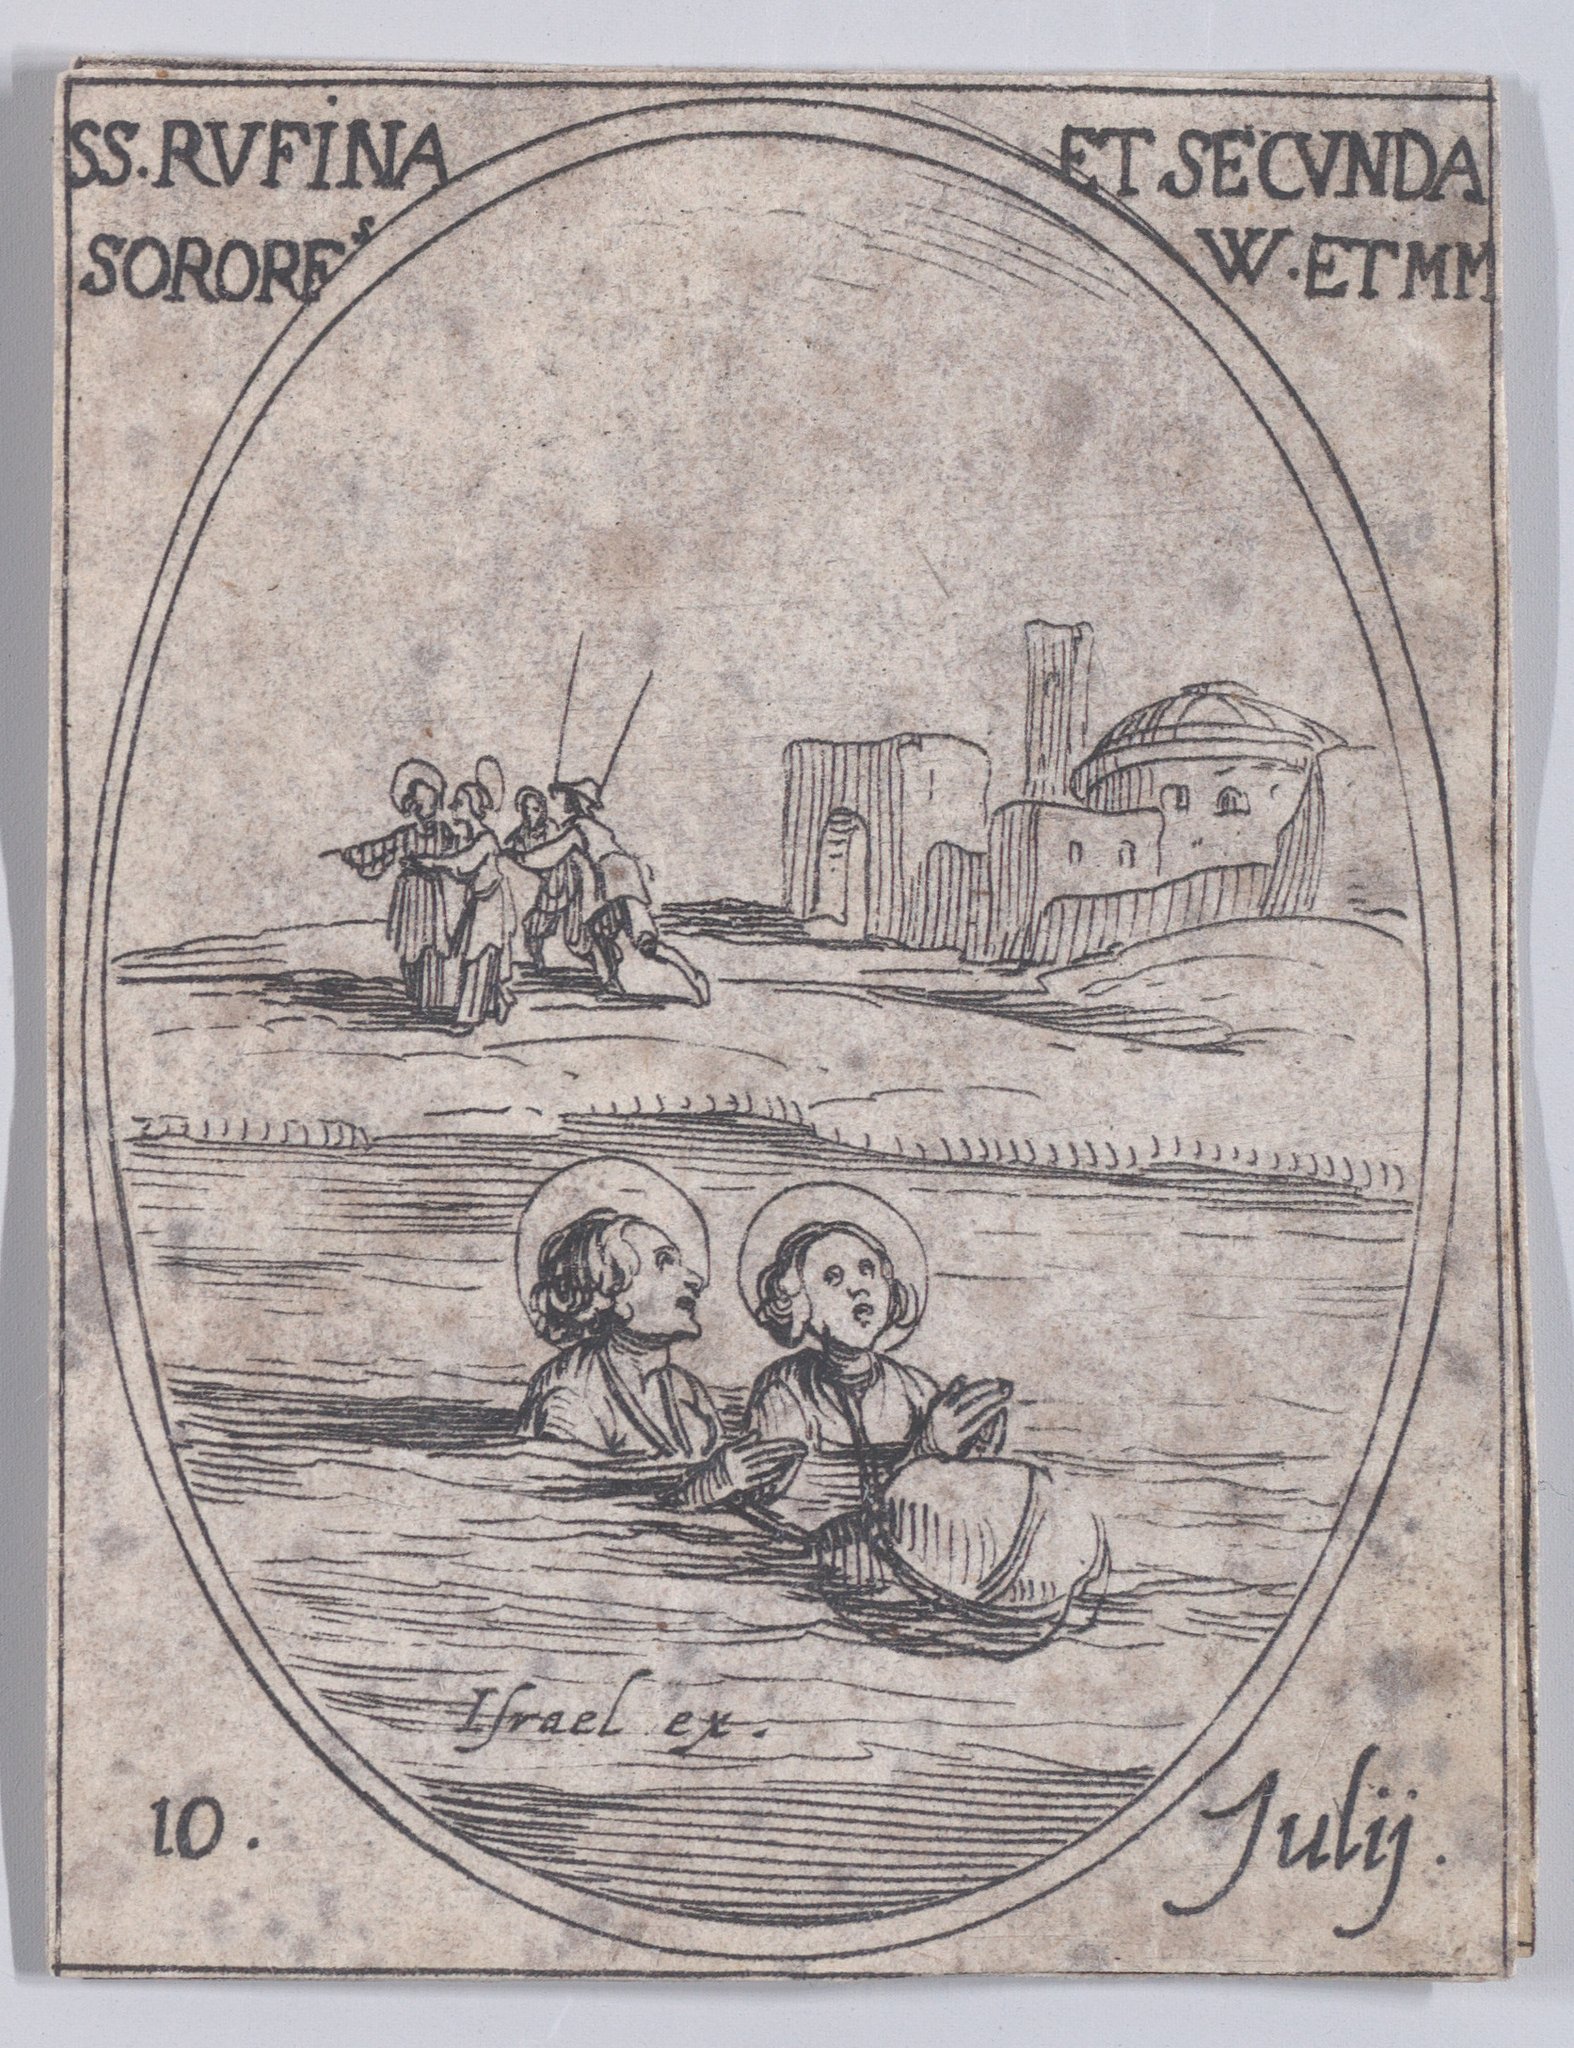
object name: print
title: Ste. Rufine e Ste. Seconde, soeurs (St. Rufina and St. Seconda, Sisters), July 10th, from "Les Images De Tous Les Saincts et Saintes de L'Année" (Images of All of the Saints and Religious Events of the Year)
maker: jacques callot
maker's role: artist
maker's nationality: french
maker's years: 1592-1635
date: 1636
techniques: etching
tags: women,saints